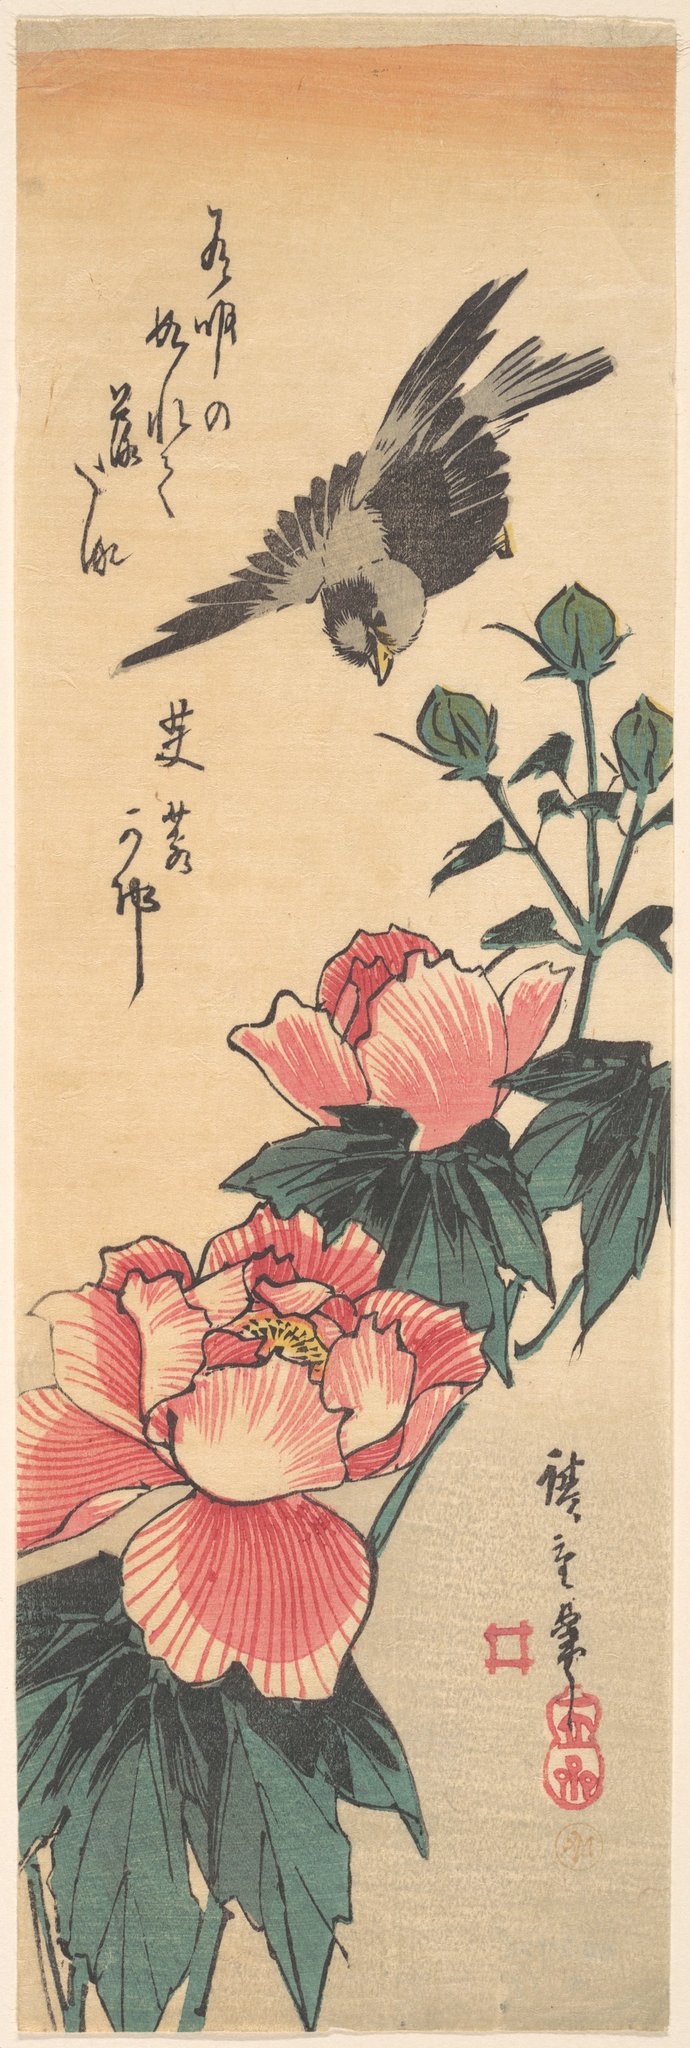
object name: print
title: Sparrow and Hibiscus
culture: japanese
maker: utagawa hiroshige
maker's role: artist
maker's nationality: japanese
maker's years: 1797-1858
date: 1834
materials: ink, paper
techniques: woodblock print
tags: birds,flowers,leaves